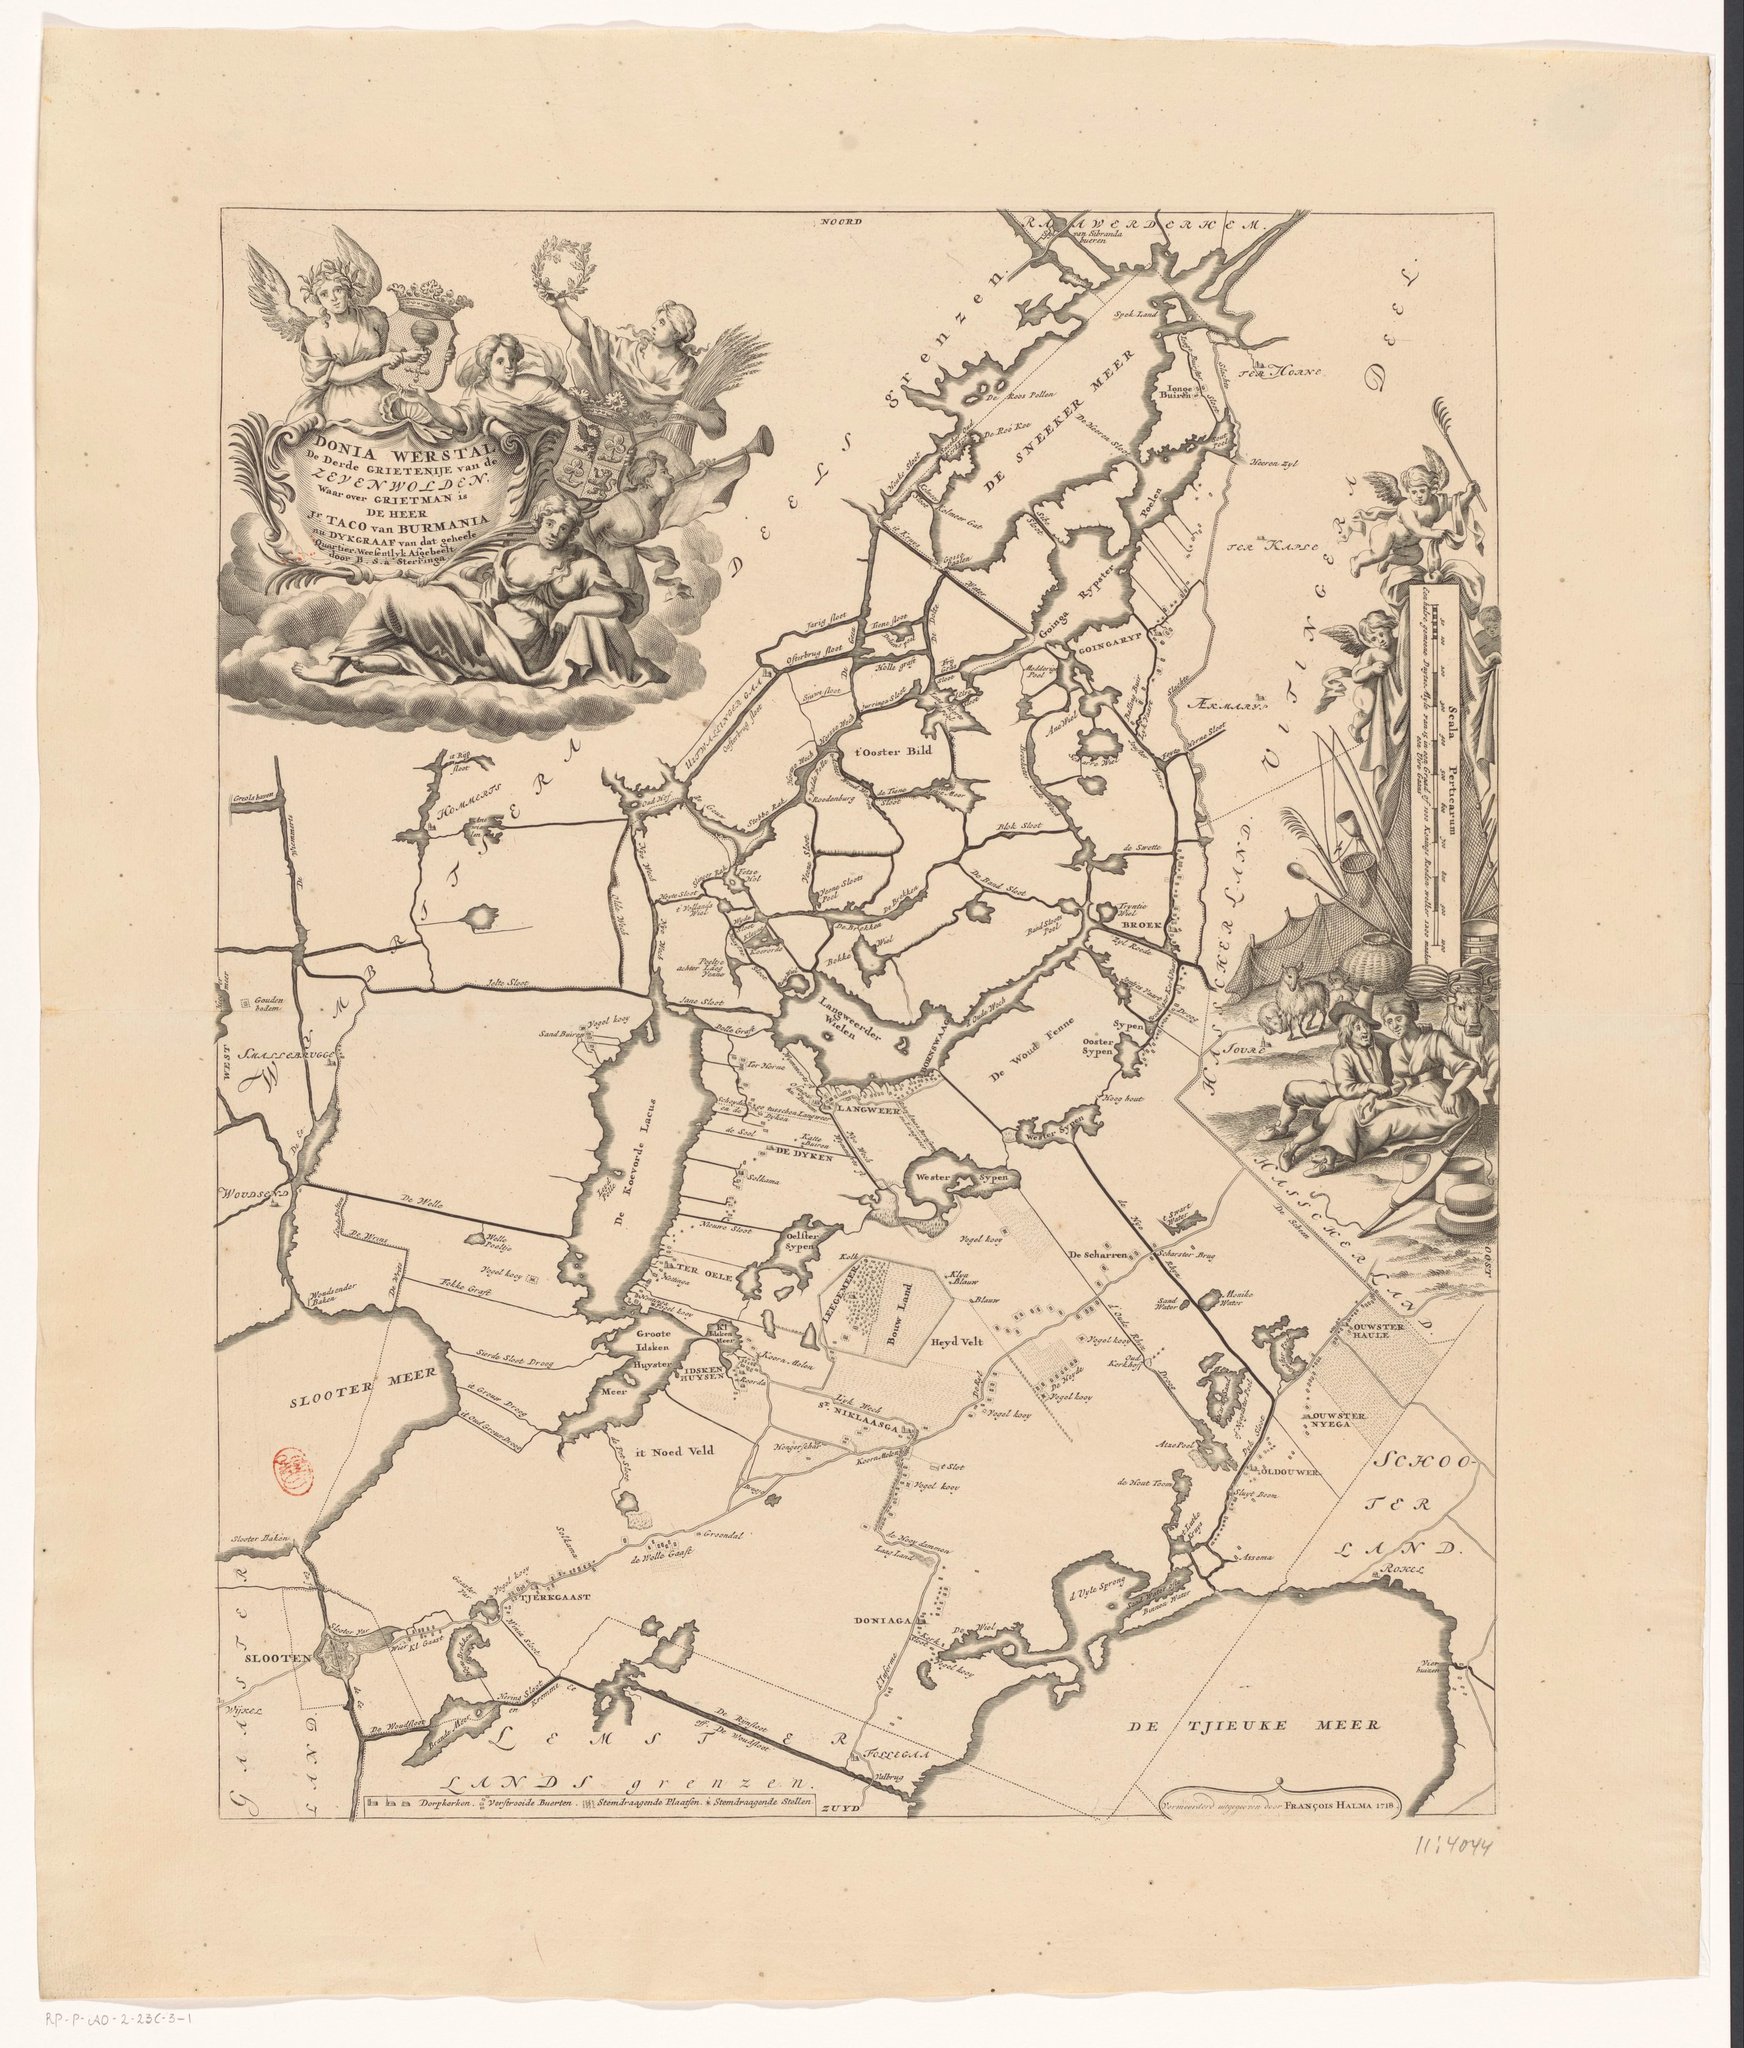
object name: print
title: Donia werstal de derde grietenije van de Zevenwolden (...)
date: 1698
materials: paper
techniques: engraving, etching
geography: friesland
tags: coat of arms (as symbol of the state, etc.), (story of) ceres (demeter), maps of separate countries or regions, fishing (sports), fame; 'fama', 'fama buona', 'fama chiara' (ripa), cheese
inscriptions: label: ‘264’, collector's mark: Lugt 2228, collector's mark: Lugt 195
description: Linksboven cartouche met titel en bestuurlijke informatie over de grietenij. Daaromheen vijf vrouwfiguren, waaronder Fama en mogelijk Ceres, en de wapens van Doniawerstal en van grietman jonker Taco van Burmania. Linksonder legenda. Rechts een schaalstok: Een halve gemeene Duytze myle van 15 in een graad of 1000 konings roeden welker 1200 maaken een uire gaans. Daaromheen putti, vissersgerei, vee, kazen en een man en een vrouw.